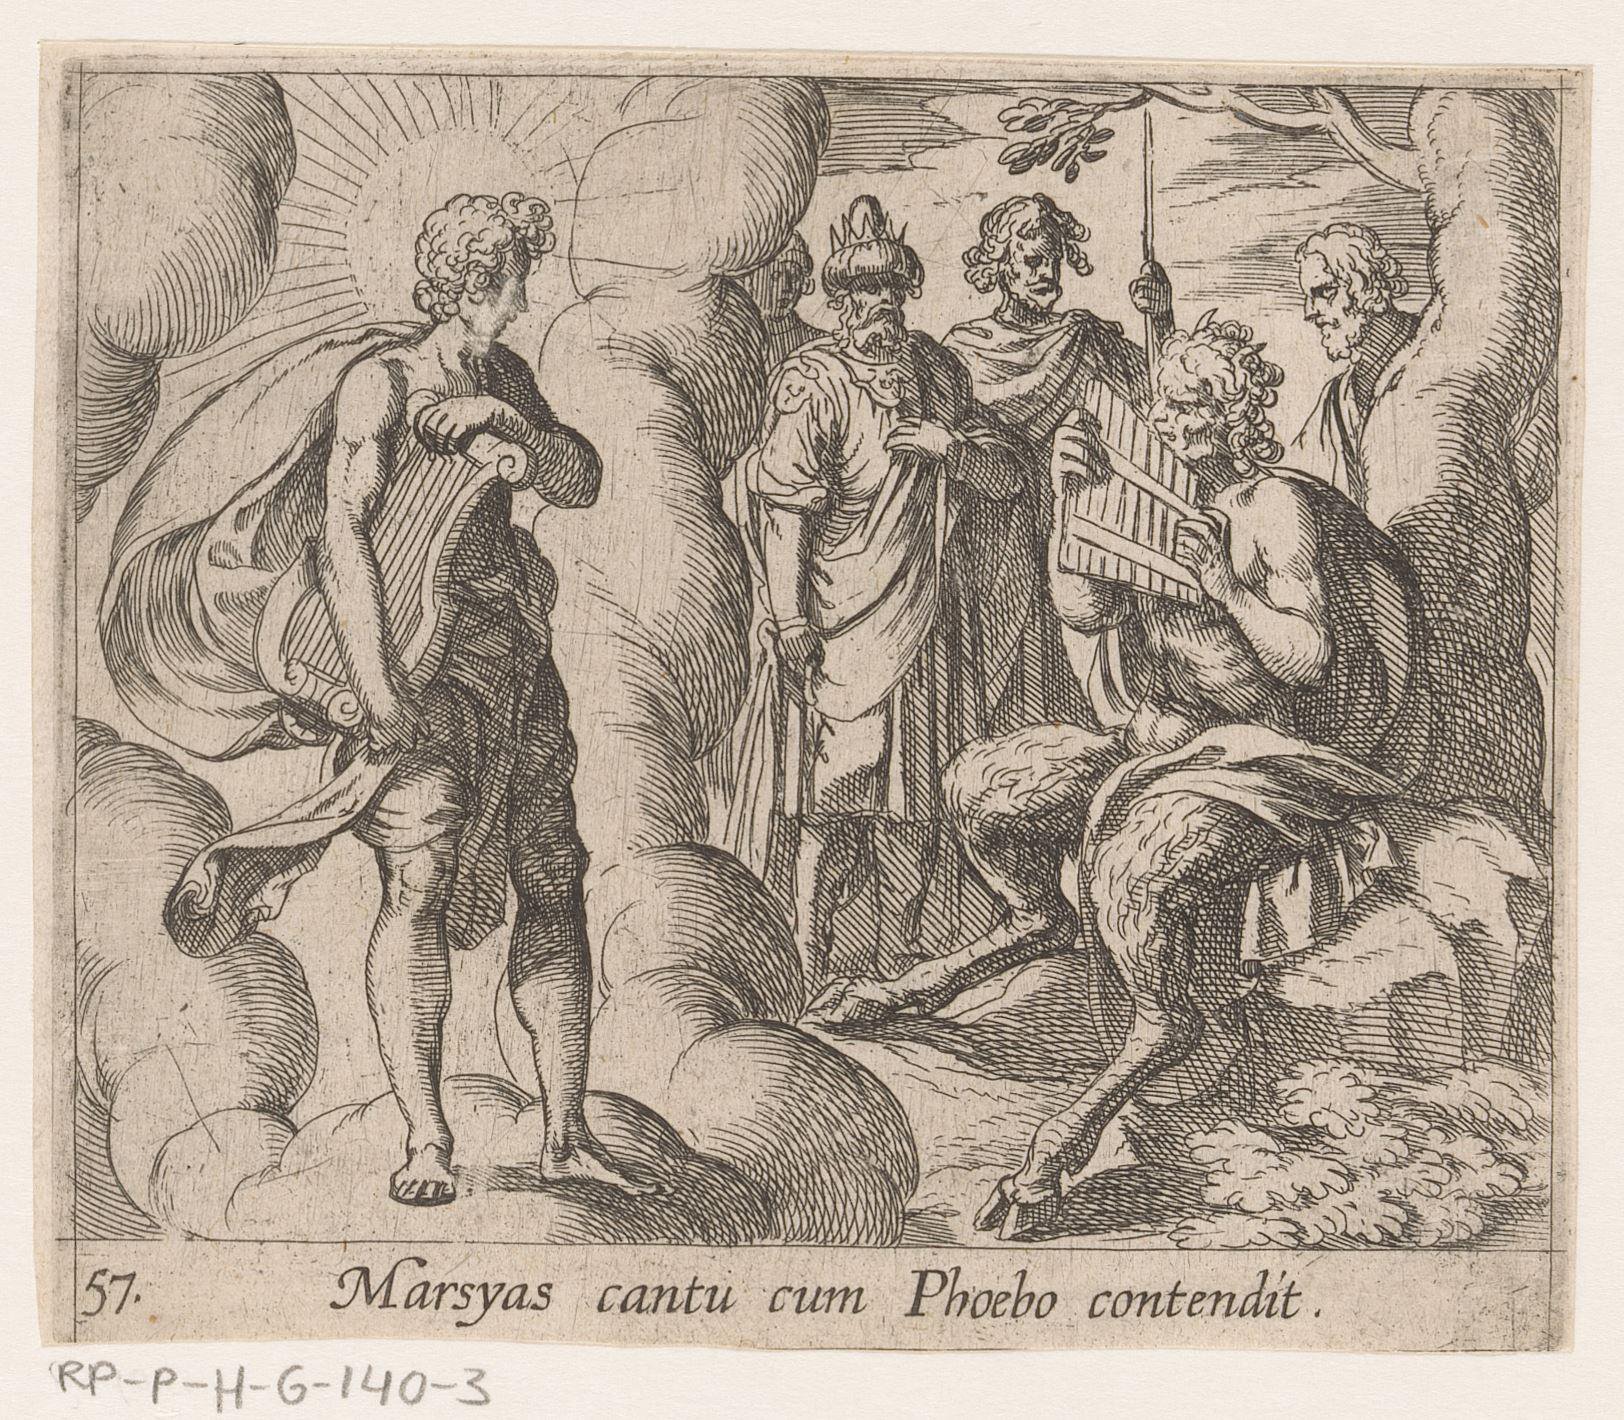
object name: print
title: Metamorfosen van Ovidius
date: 1606-1638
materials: paper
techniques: etching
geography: amsterdam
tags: contest of apollo and marsyas in which midas gives judgement (hyginus, 'fabularum liber' 191)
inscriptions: collector's mark: ‘Hinloopen’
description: Apollo en de sater Marsyas houden een muziekwedstrijd tussen fluit en lier. Marsyas speelt op zijn fluit. Titel in het Latijn in ondermarge.